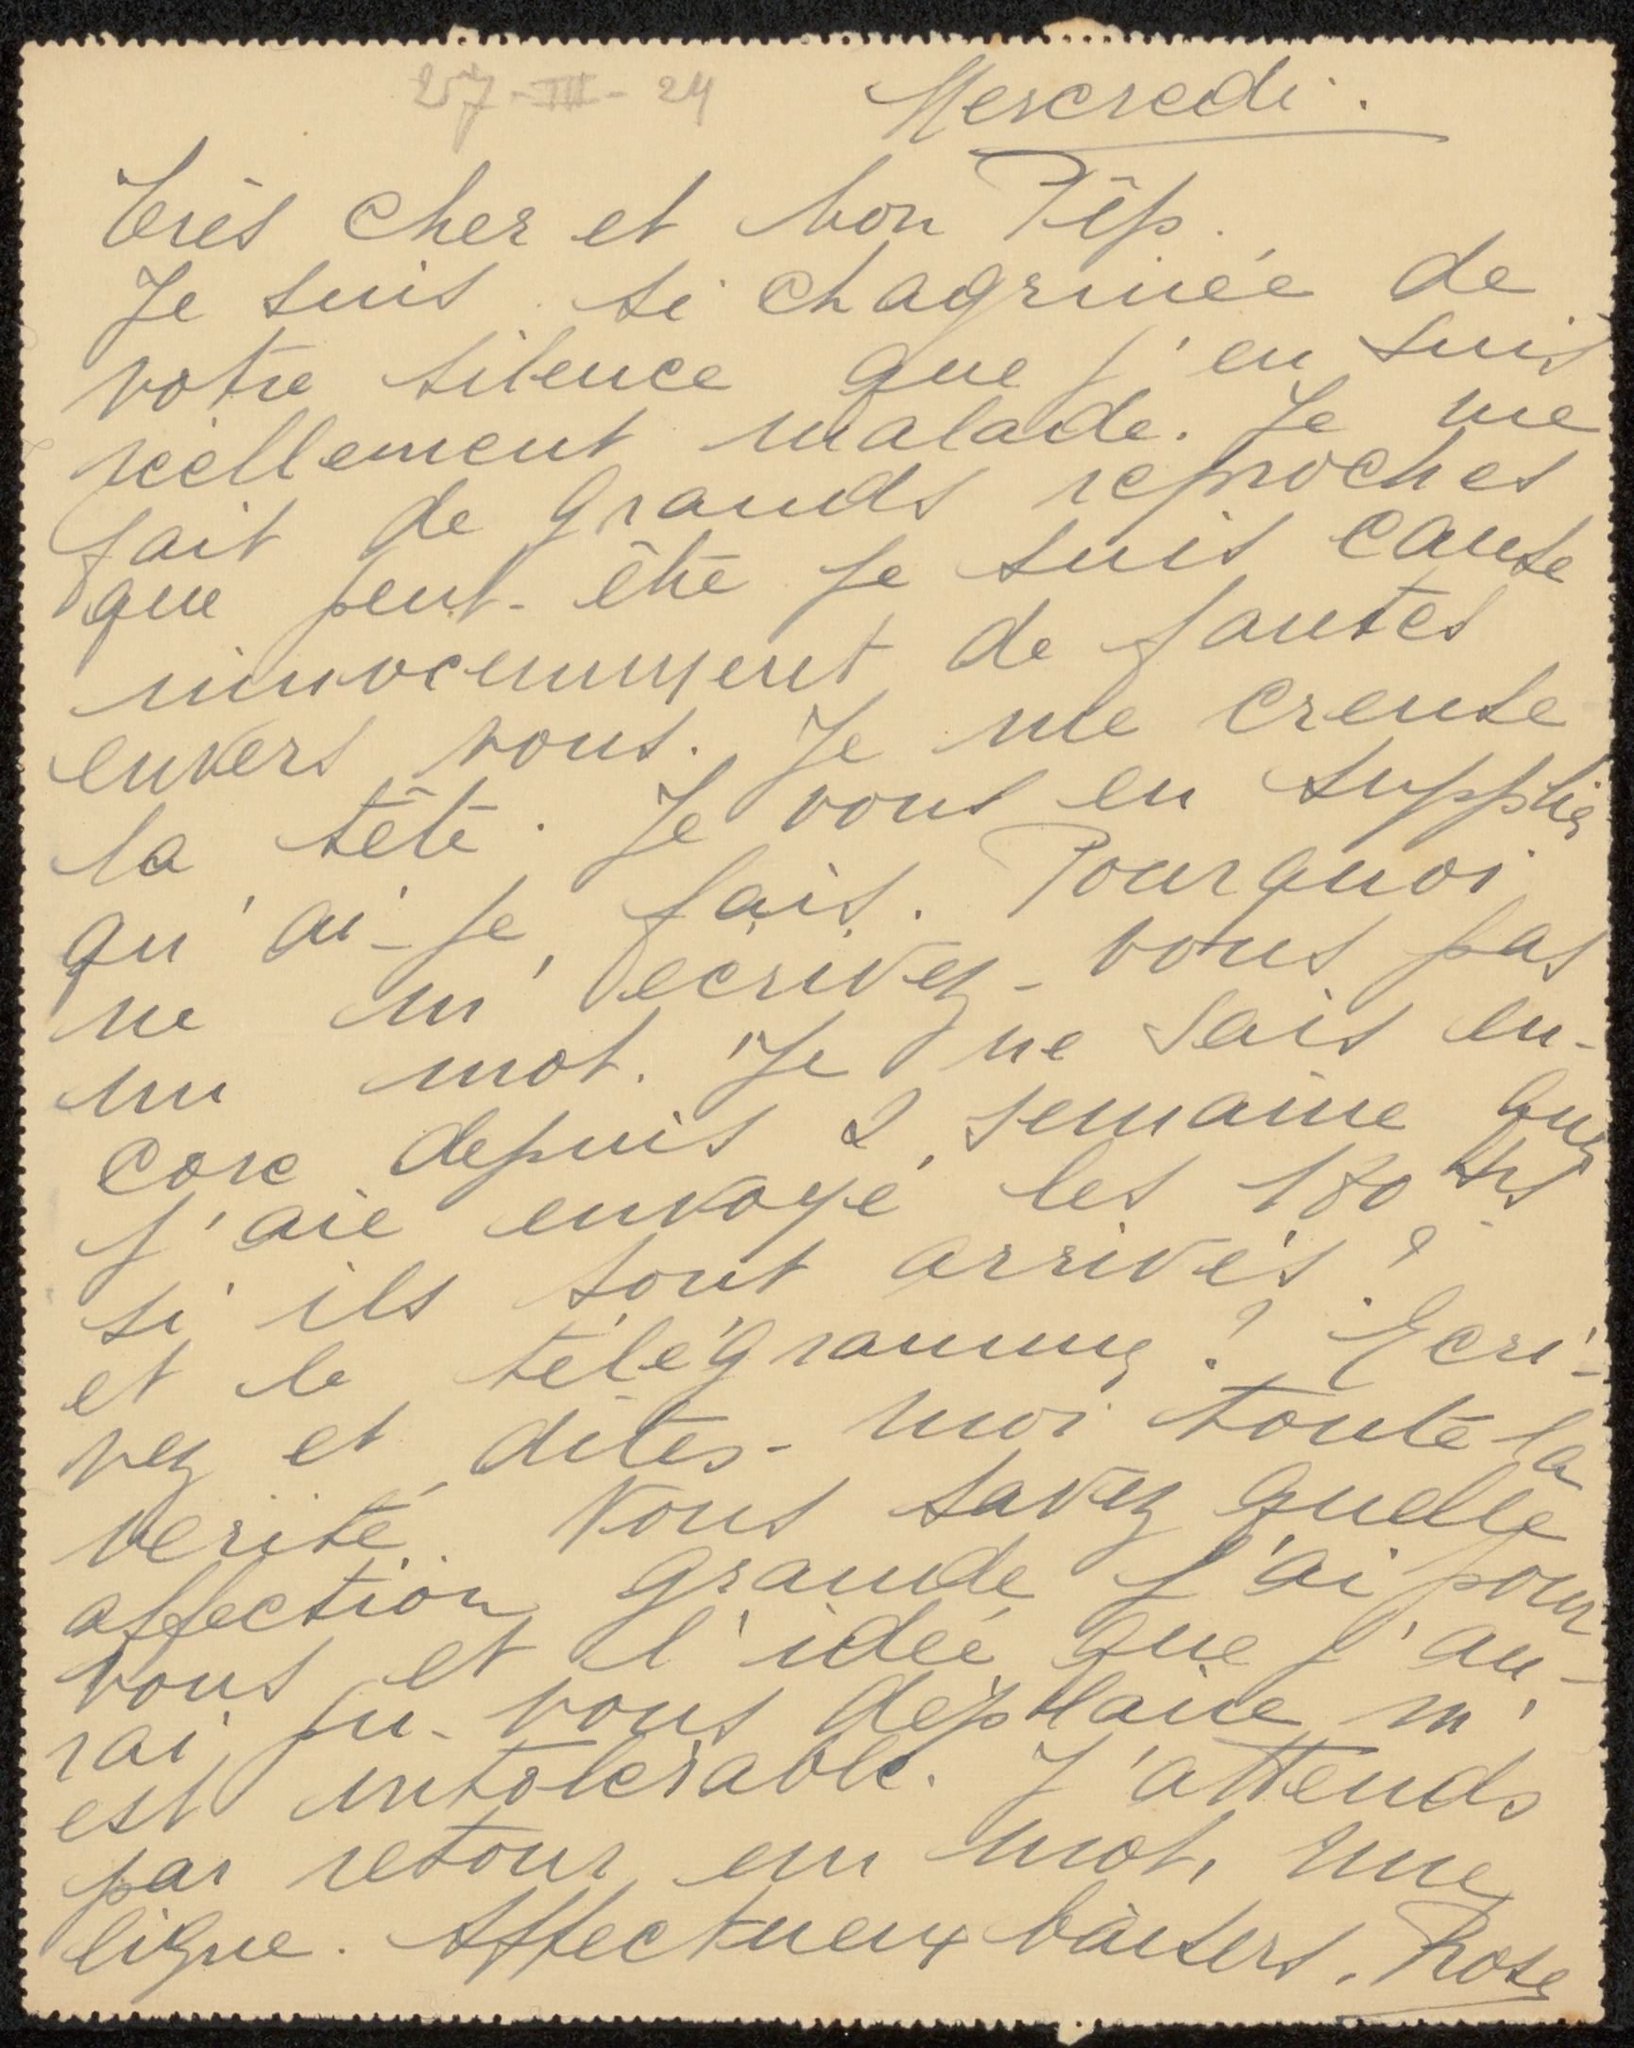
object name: letter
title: Brief aan Philip Zilcken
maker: rose imel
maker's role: draughtsman, painter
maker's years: 1901-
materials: ink, paper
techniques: pen, writing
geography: paris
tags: the hague, painter, draughtsman, philip zilcken, diseases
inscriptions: collector's mark: ‘RPK’